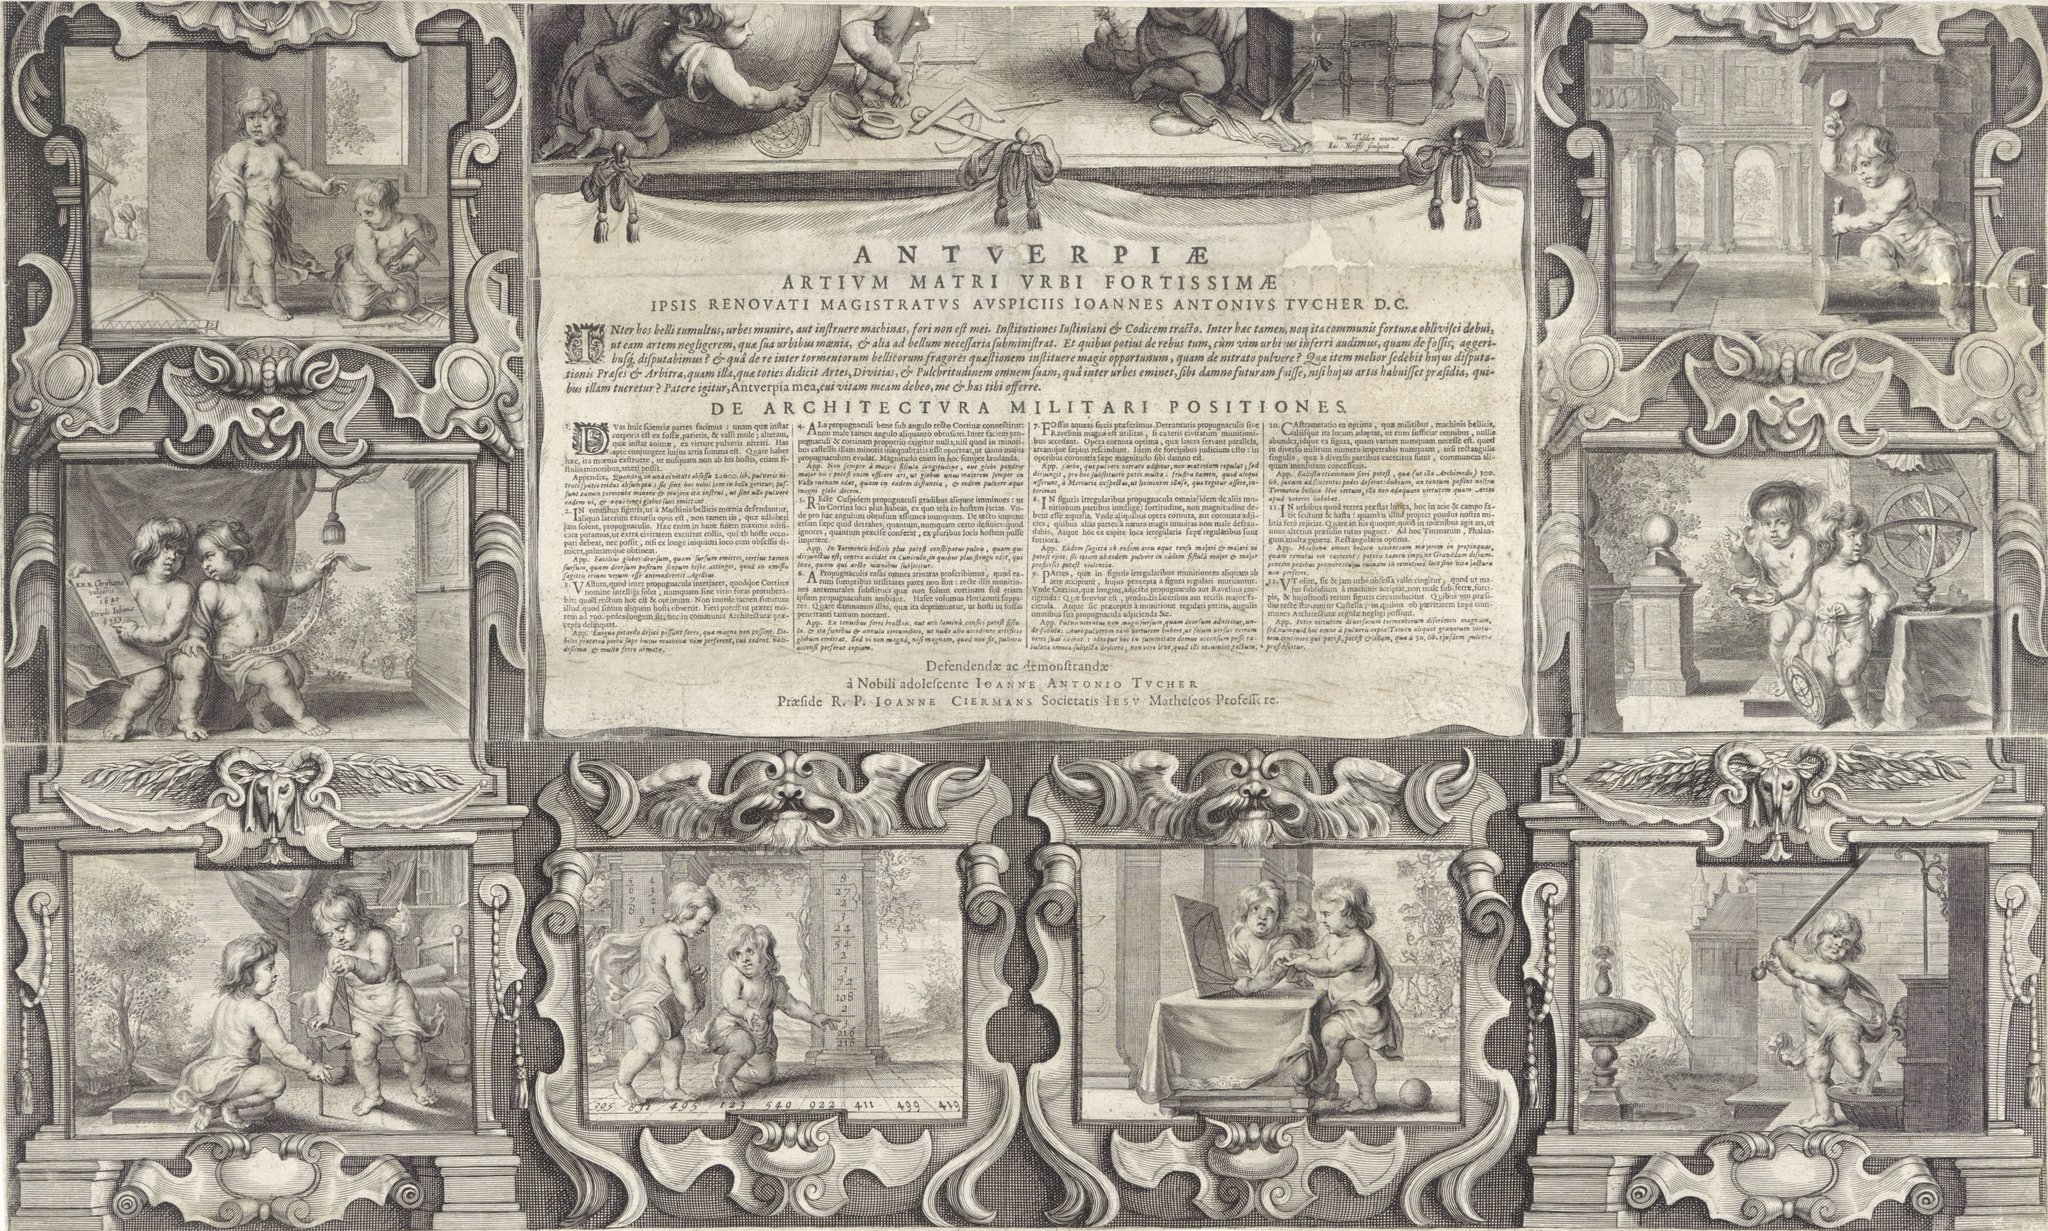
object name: print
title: Antverpiae artium matri urbi fortissimae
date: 1640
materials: paper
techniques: engraving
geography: antwerp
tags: the four cardinal virtues (+ angel(s)), fortifications, military engineering, cupids: 'amores', 'amoretti', 'putti', mathematics, antwerp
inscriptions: collector's mark: Lugt 2228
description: Onderste gedeelte van de voorstelling met de Stedenmaagd van Antwerpen omgeven door allegorische voorstellingen. In de omlijsting beoefenen putti allerlei ambachten en vaardigheden, die te maken hebben met de architectuur van militaire aanval- en verdedigingswerken en wiskunde. Onder de voorstelling van de Antwerpse stedenmaagd een tekst in het Latijn over de fortificaties van de stad Antwerpen, die werden vernieuwd door Jan Antoon Tucher. Jezuiet en wiskundeprofessor Joannes Ciermans was de voorzitter van het project.